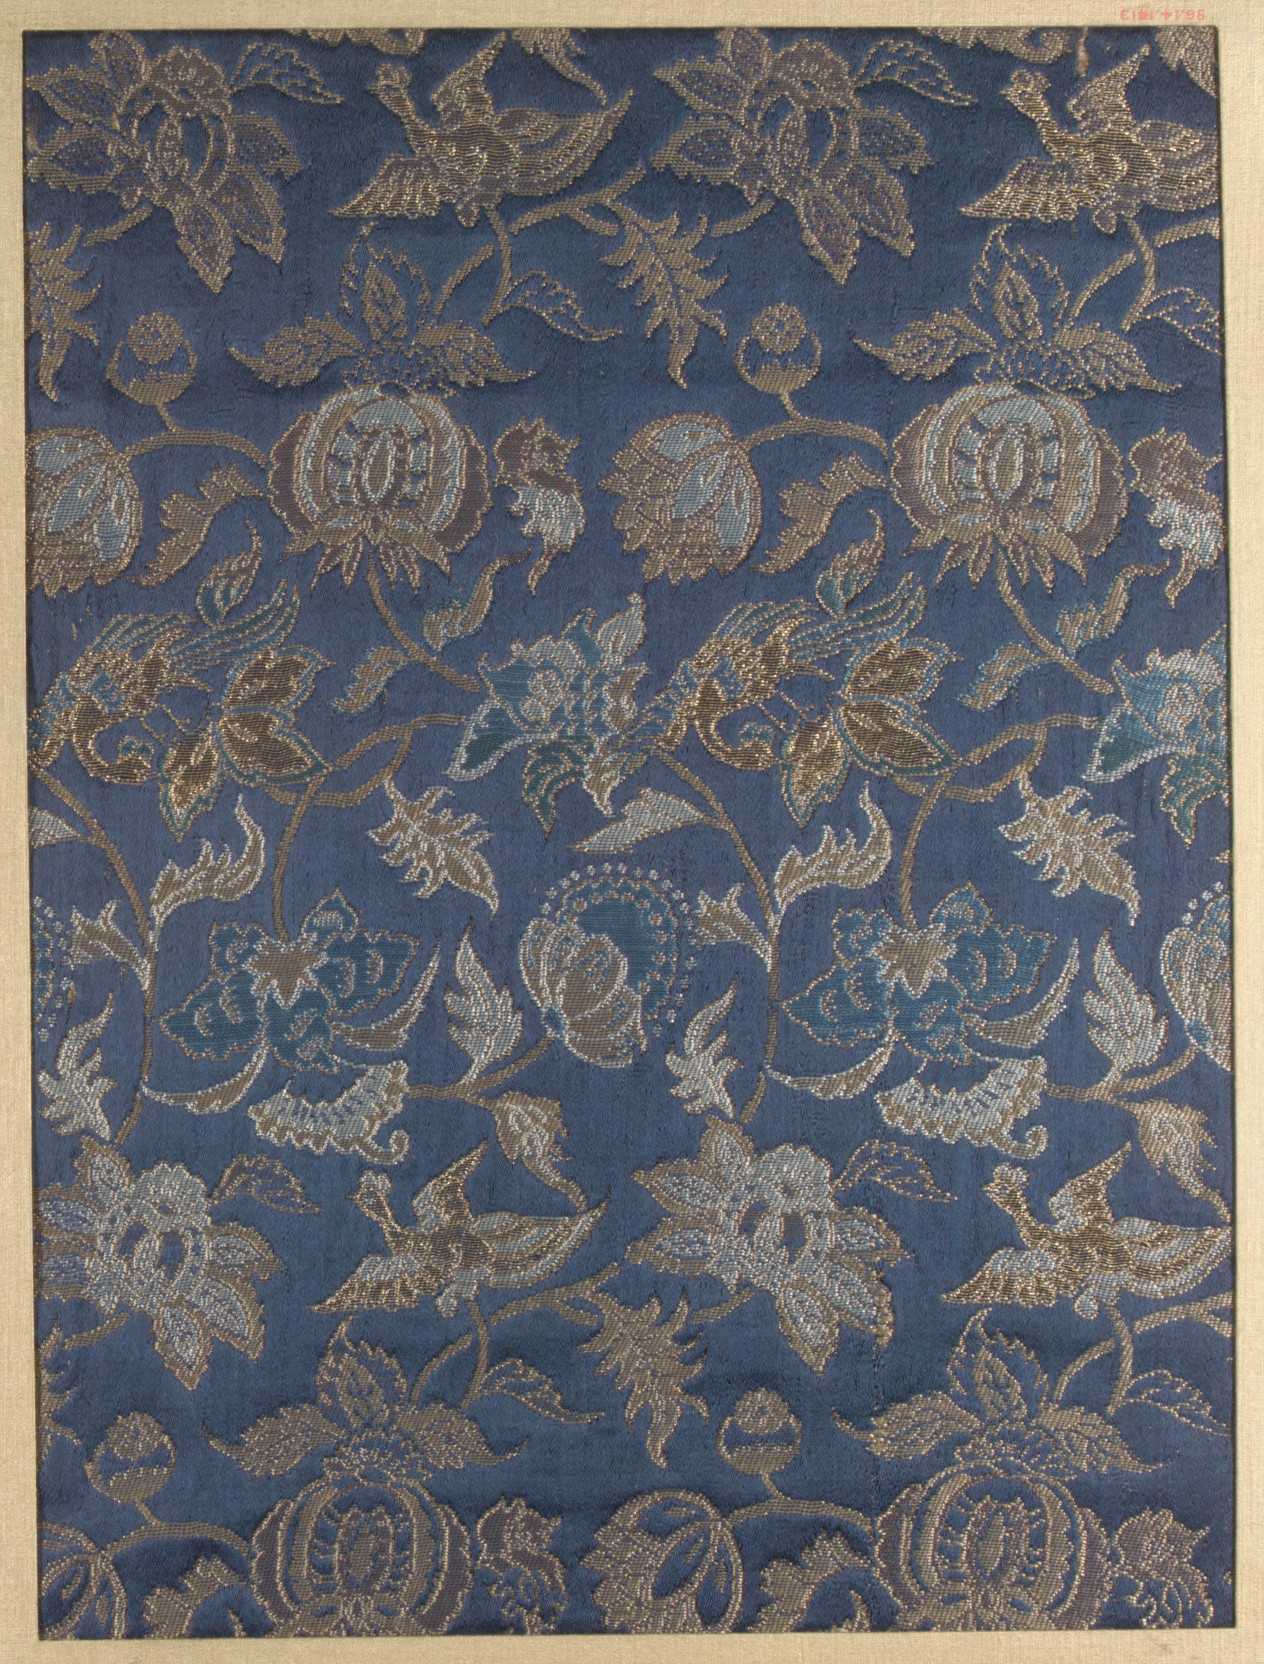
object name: piece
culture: japanese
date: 1701-1900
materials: silk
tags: birds,flowers